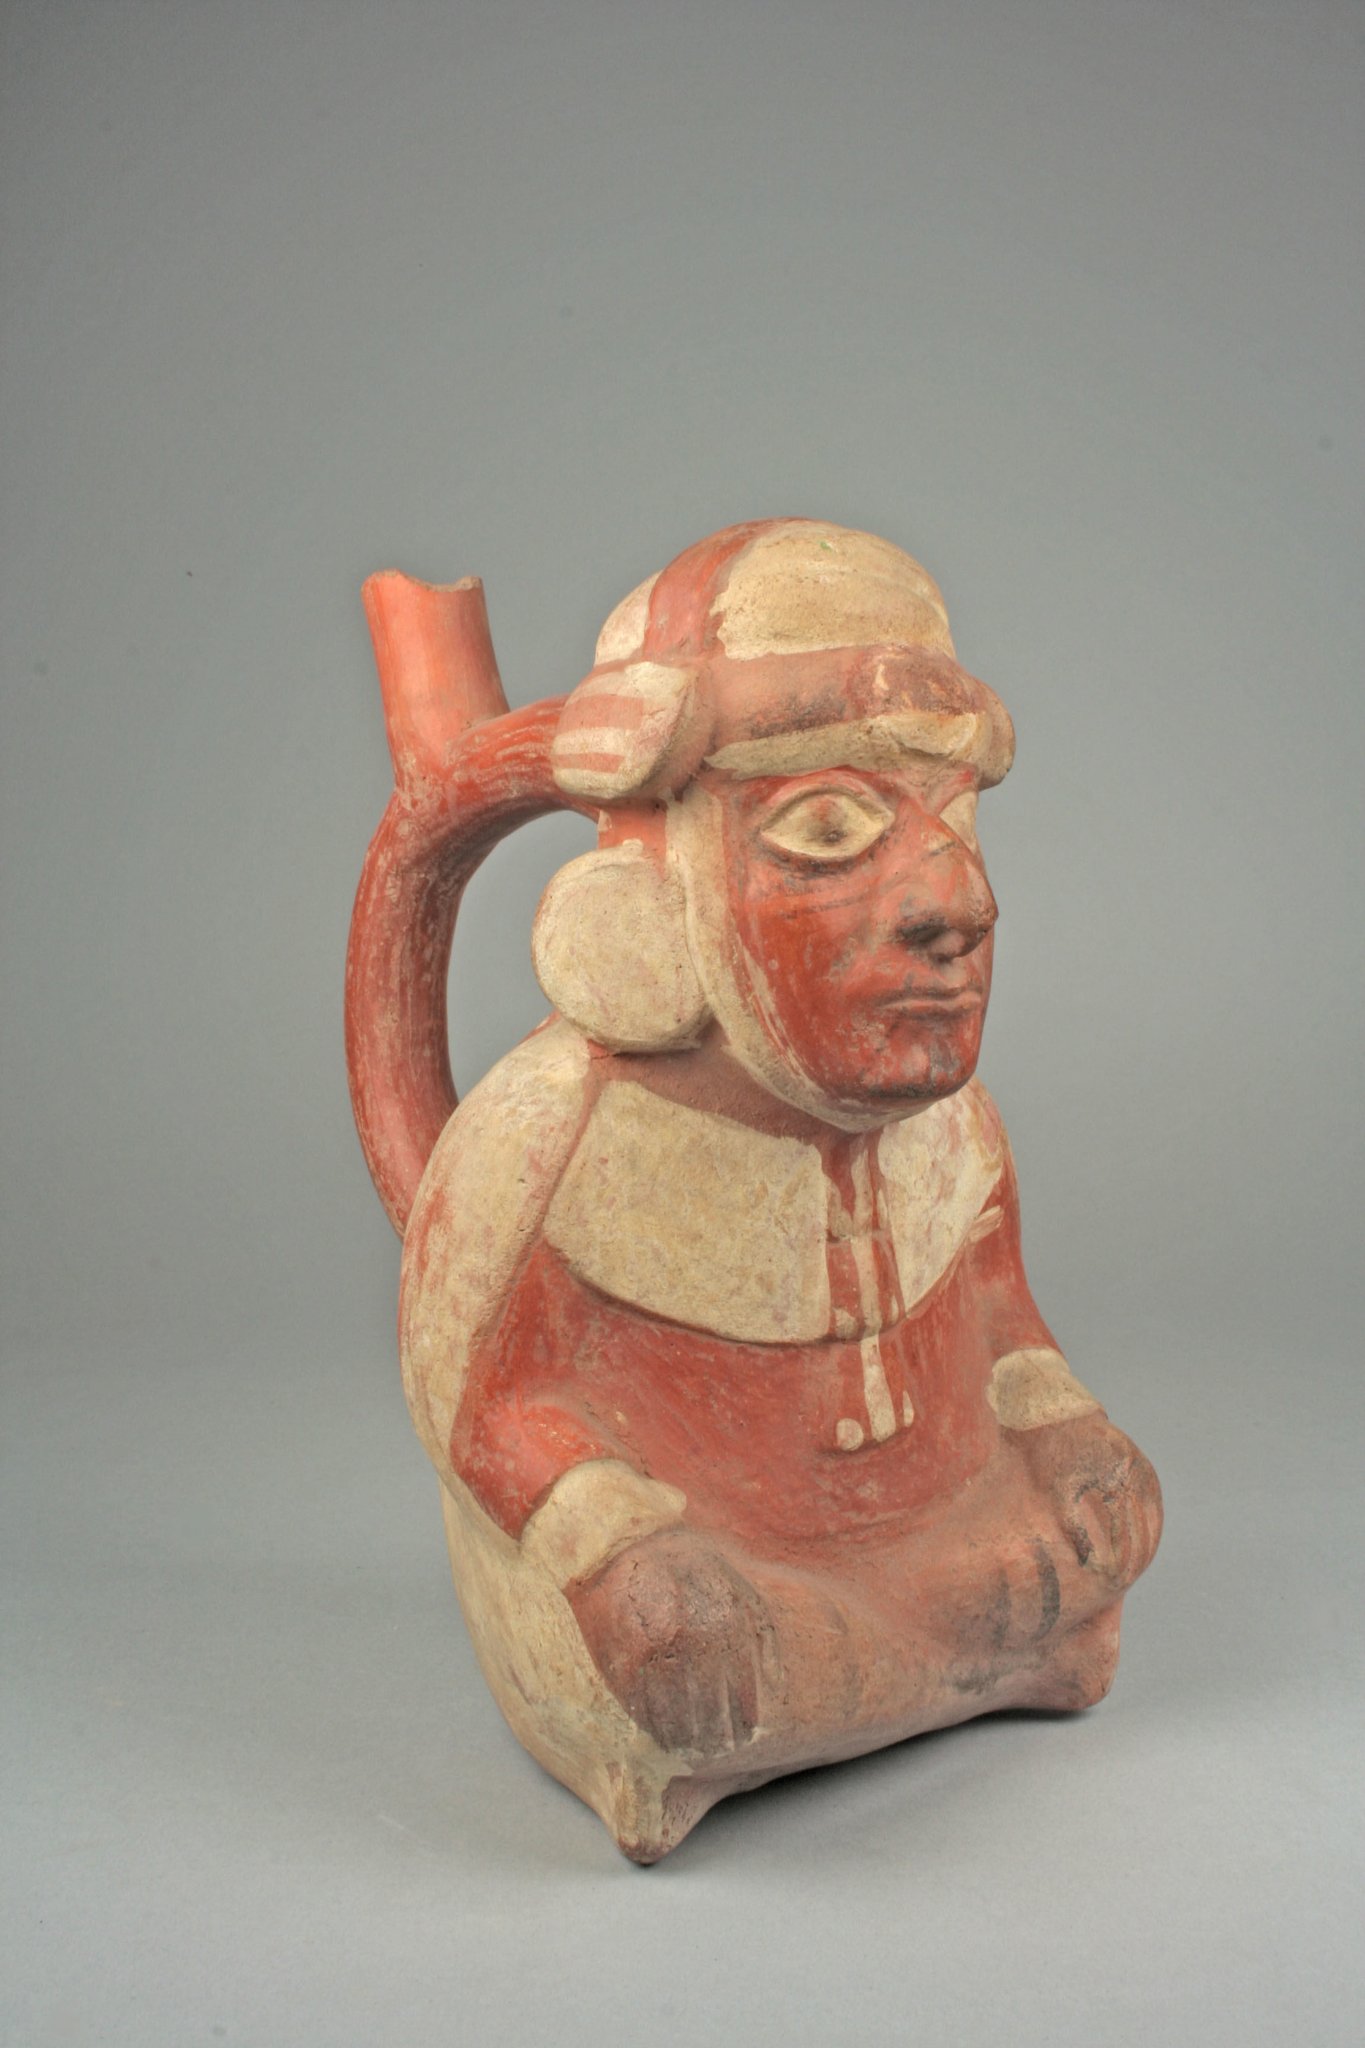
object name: bottle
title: Bottle, Seated Figure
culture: moche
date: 401-700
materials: ceramic, pigment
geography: peru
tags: men